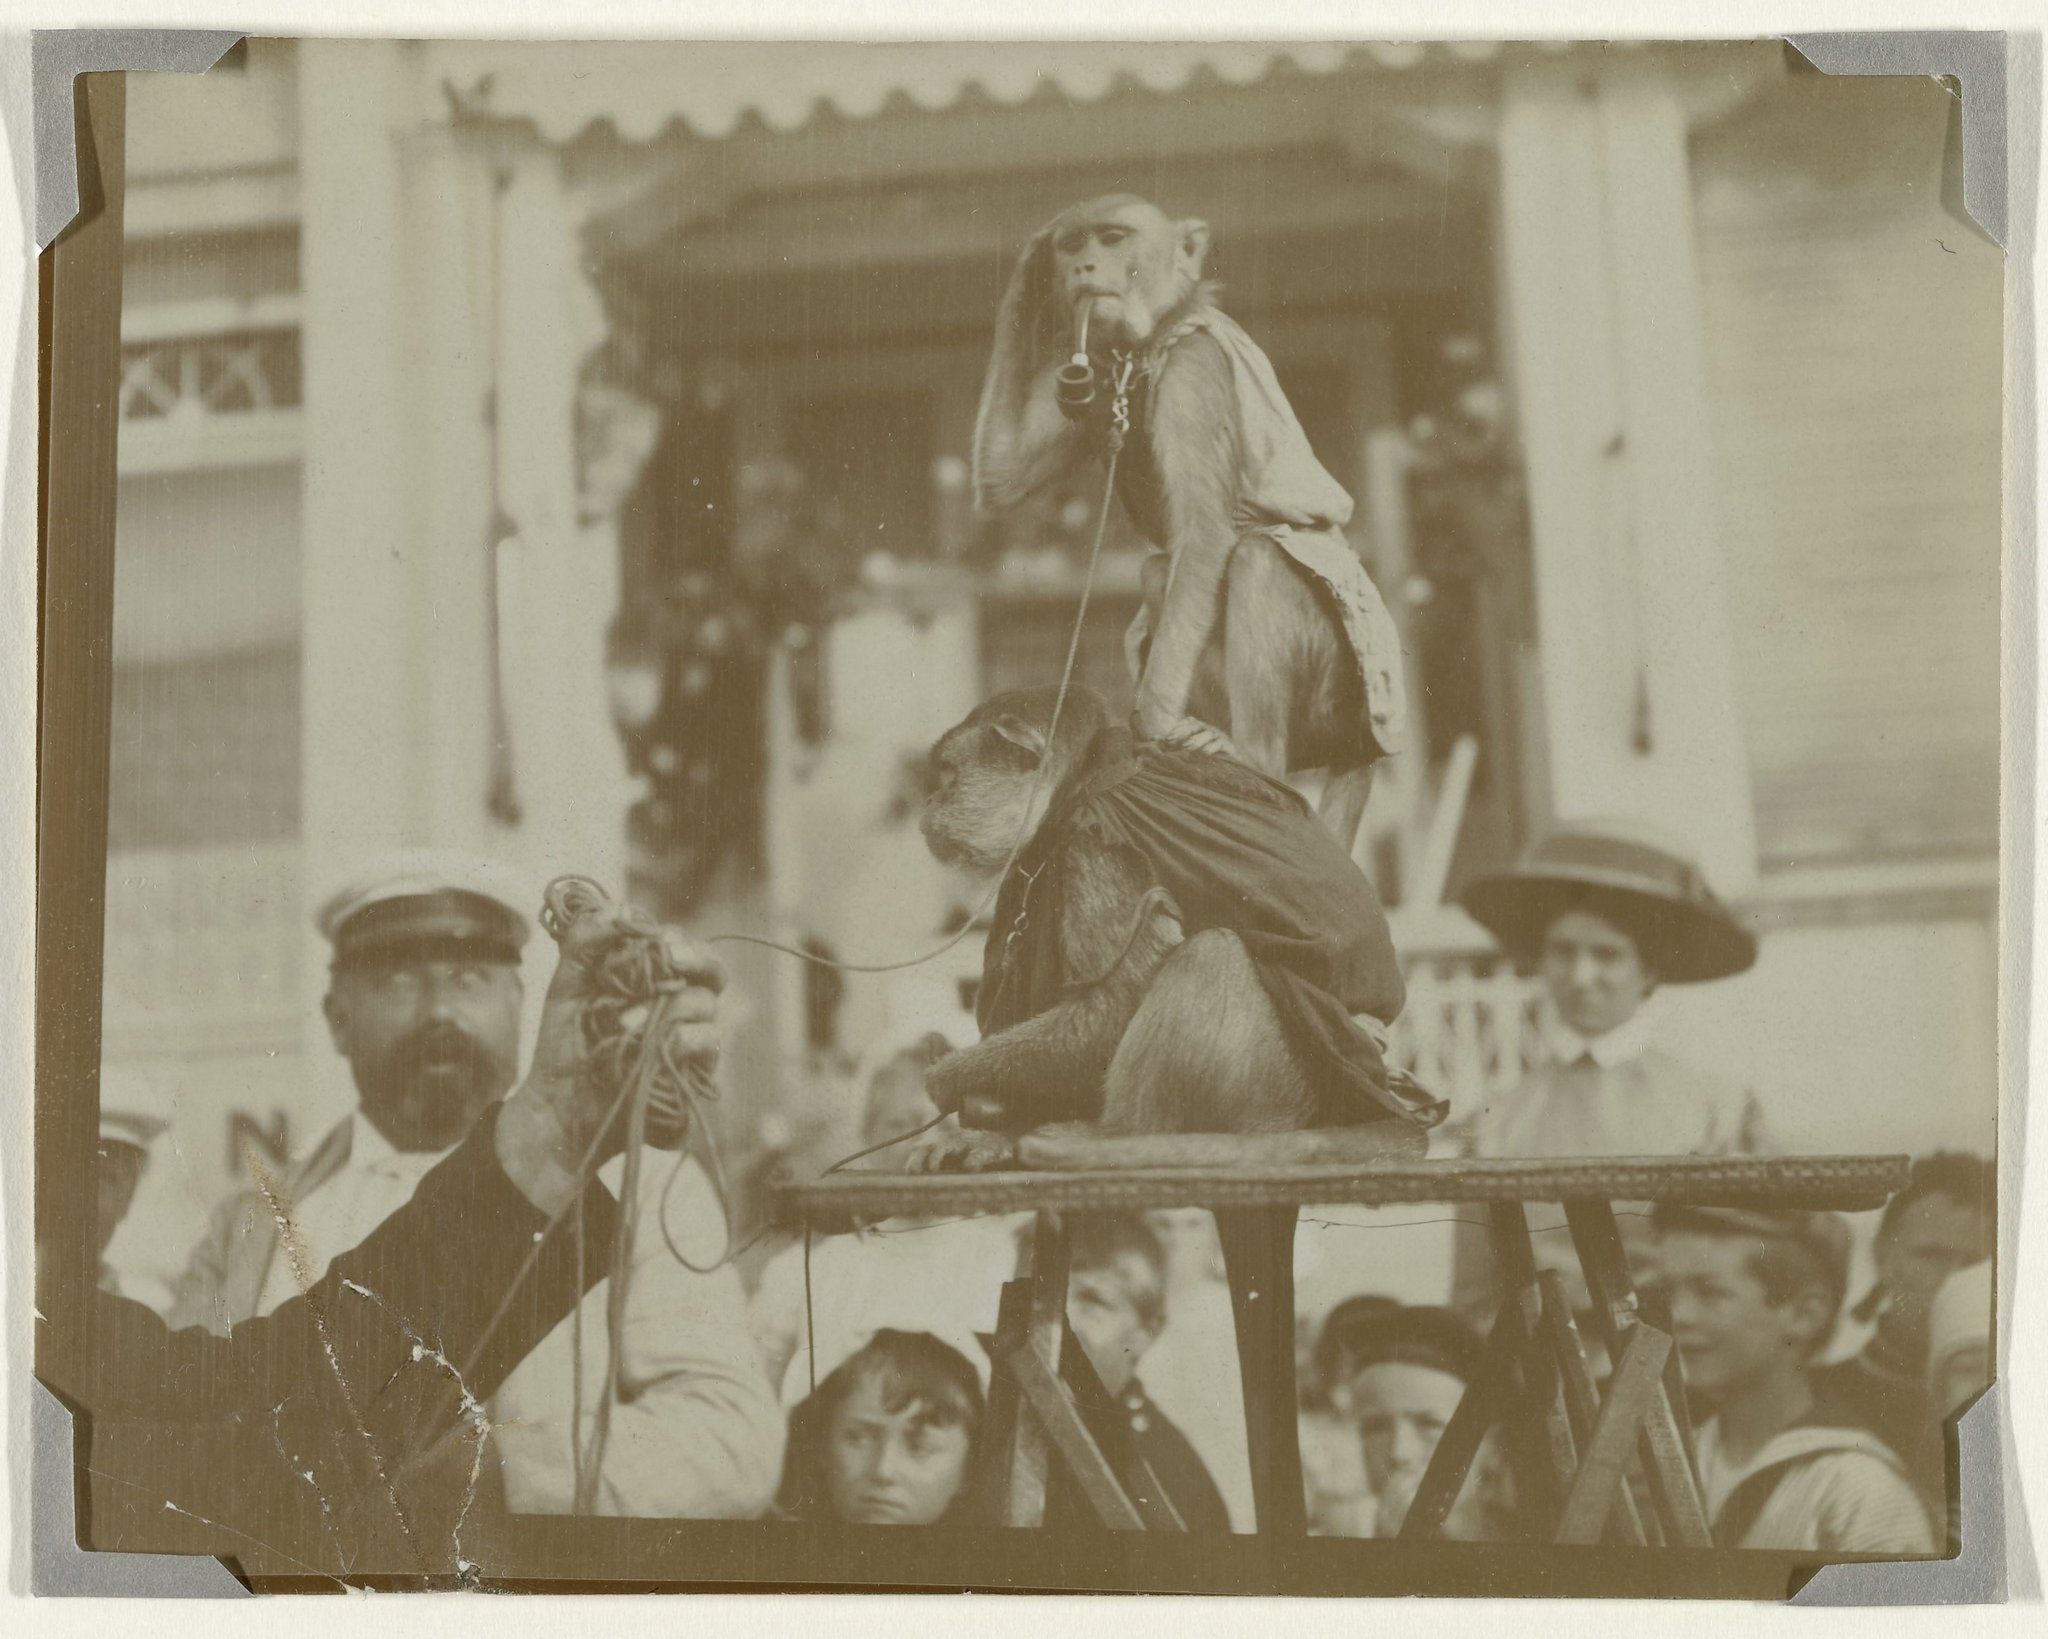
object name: photograph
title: Twee apen, met toeschouwers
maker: Anonymous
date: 1900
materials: paper, photographic support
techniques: gelatin silver print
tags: monkeys, apes, earning money with monkey